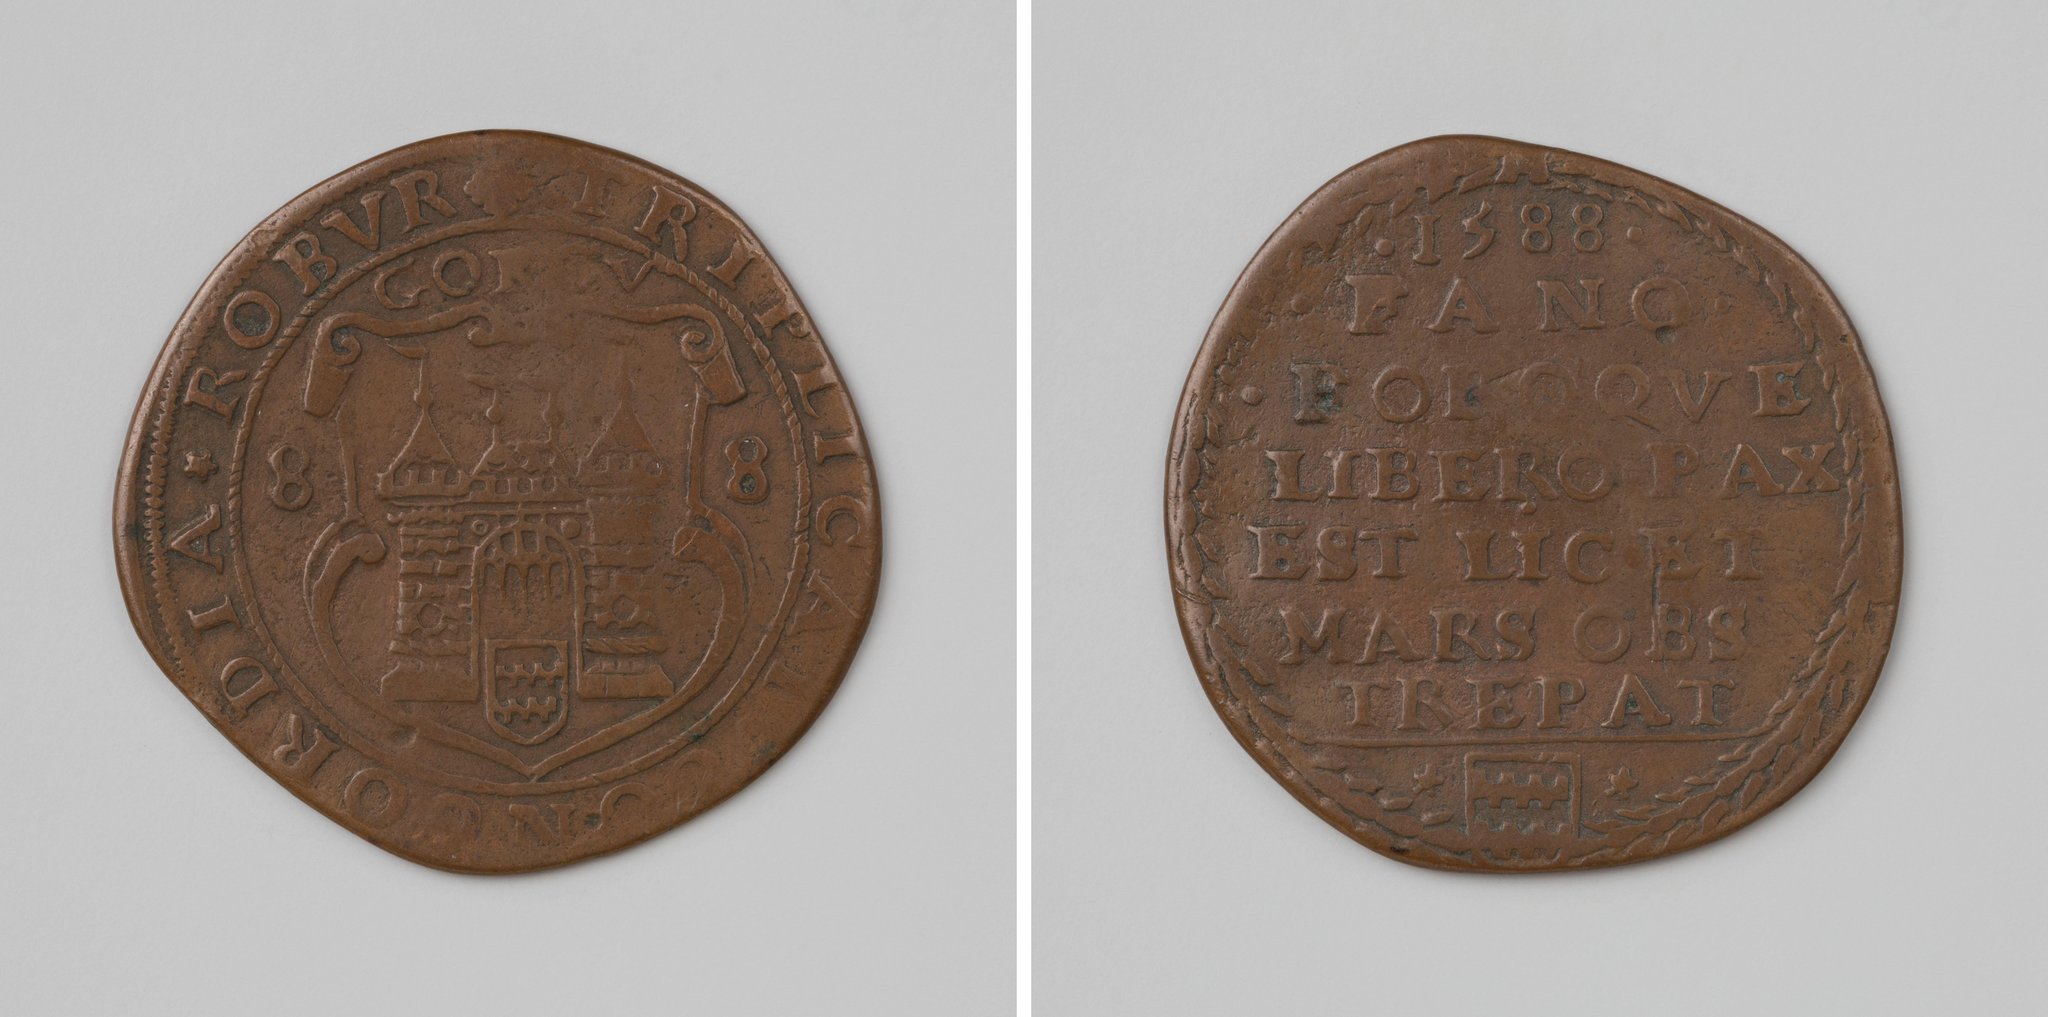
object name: jeton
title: Waarschuwing tegen de onderhandelingen te Broekburg met Spanje, rekenpenning van de stad Gorinchem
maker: Anonymous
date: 1588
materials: copper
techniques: striking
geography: netherlands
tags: bourbourg, gorinchem, onderhandelingen te broekburg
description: Koperen penning. Voorzijde: wapenschild in cartouche tussen jaartal onder opschrift binnen omschrift. Keerzijde: opschrift binnen lauwerkrans; afsnede: wapenschild en jaartal